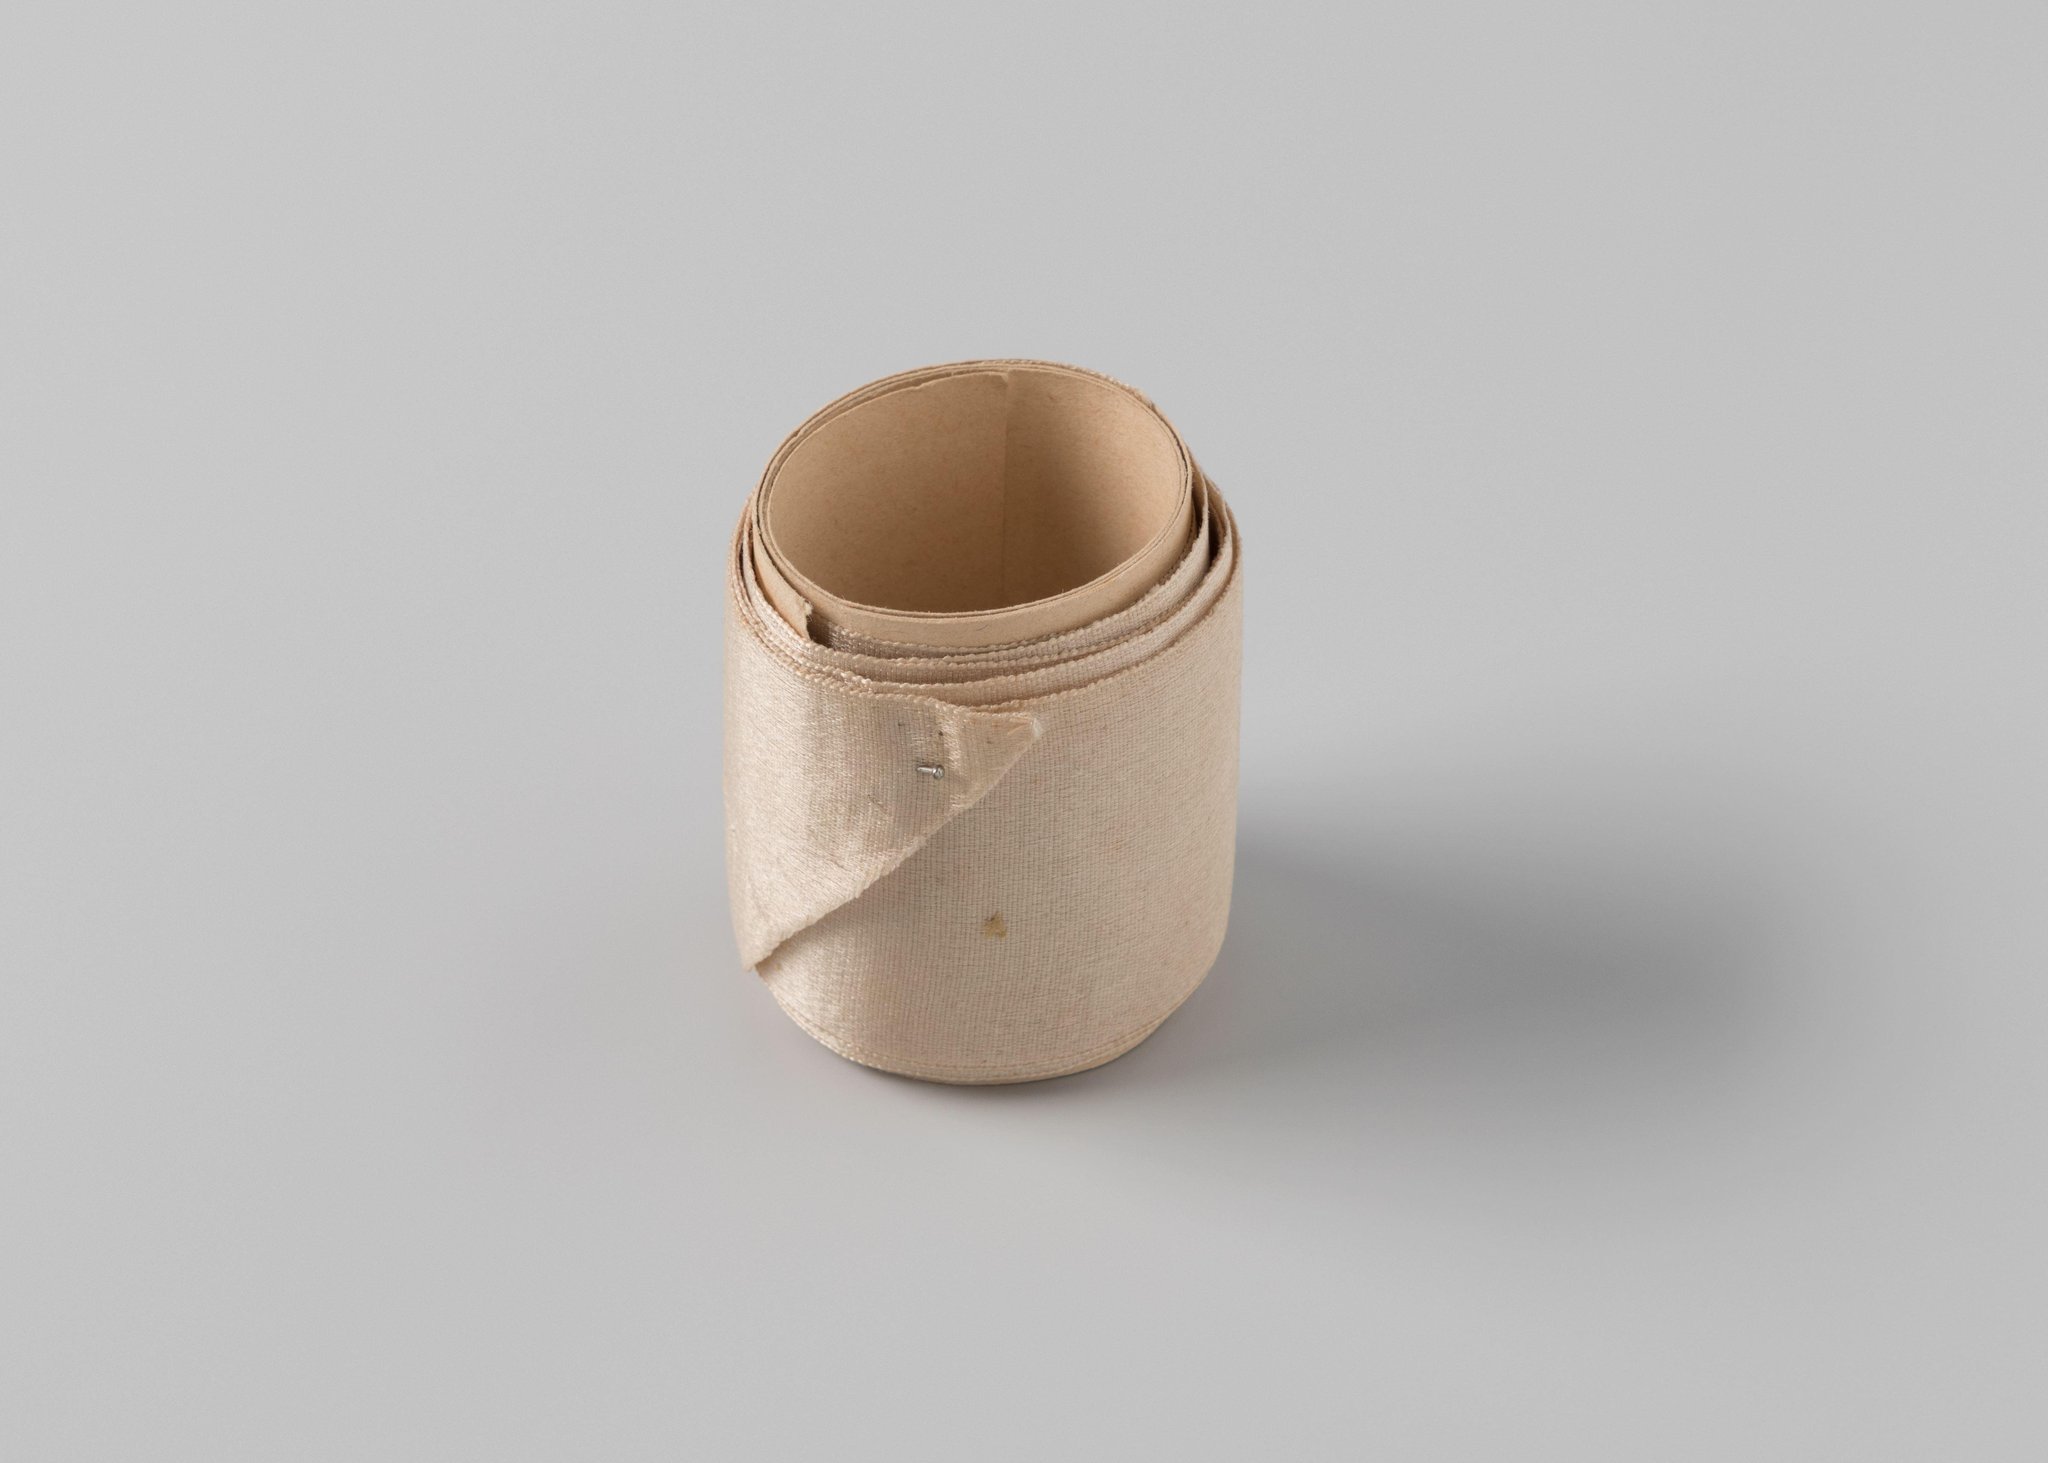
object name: ribbon material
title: Rol crème zijden satijnlint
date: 1925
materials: silk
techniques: satin binding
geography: france